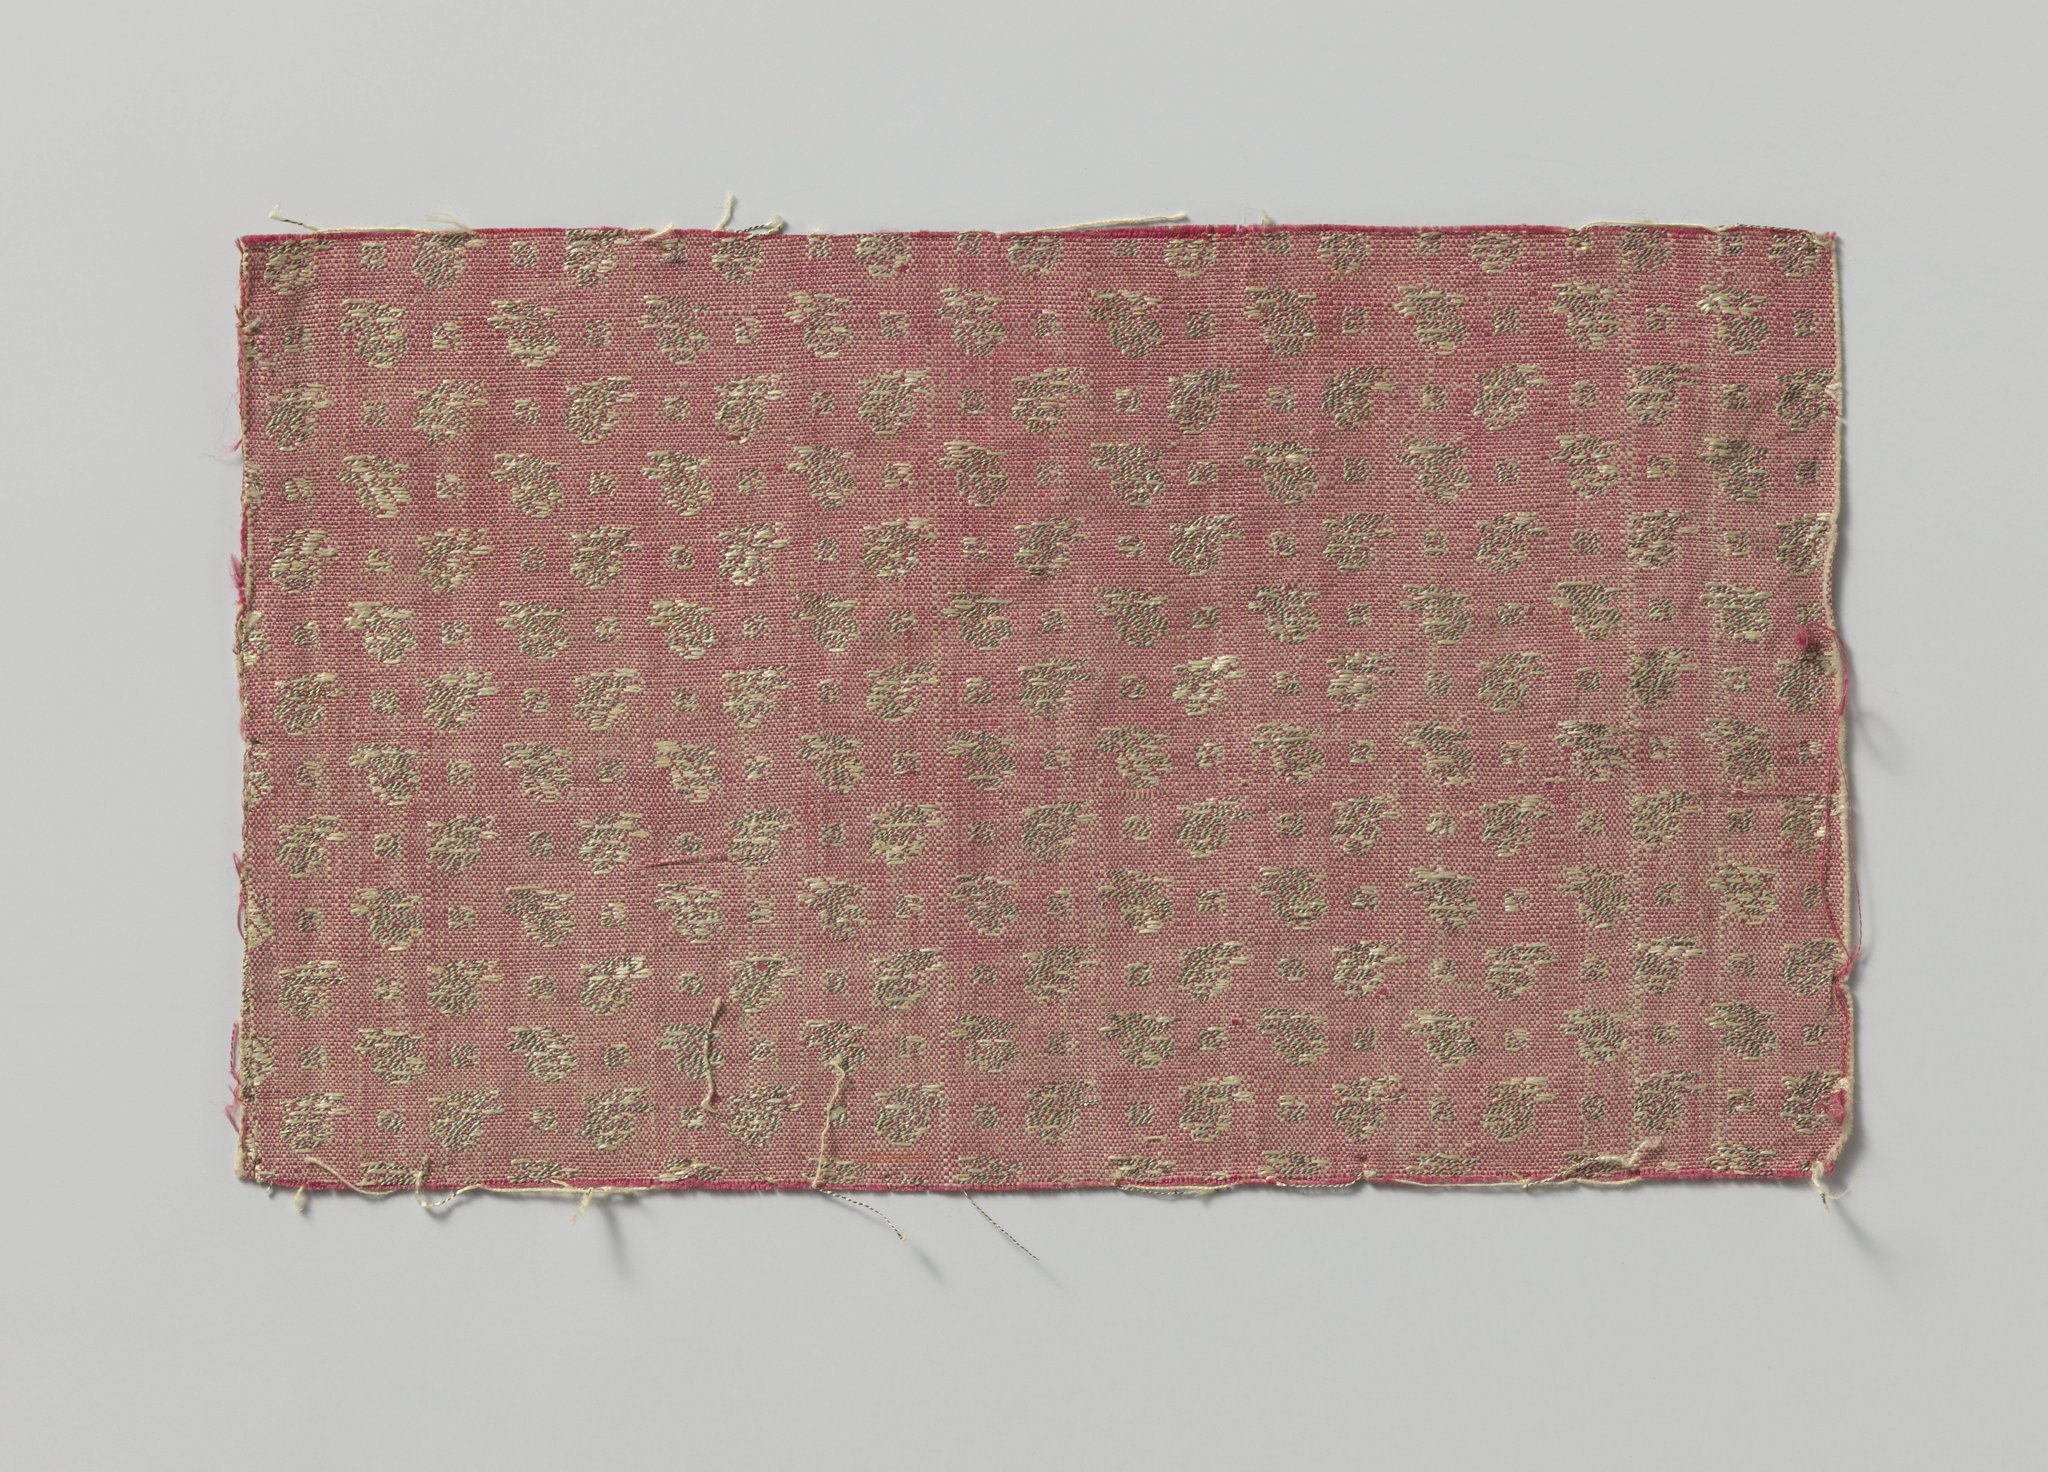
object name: fragment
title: Fragment oosterse textiel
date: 1800-1850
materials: cotton, silk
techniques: brocade, weave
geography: india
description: Fragment oosterse textiel met een gestrooid patroon van grote en kleine gouden gestileerde bladeren op een rode grond.